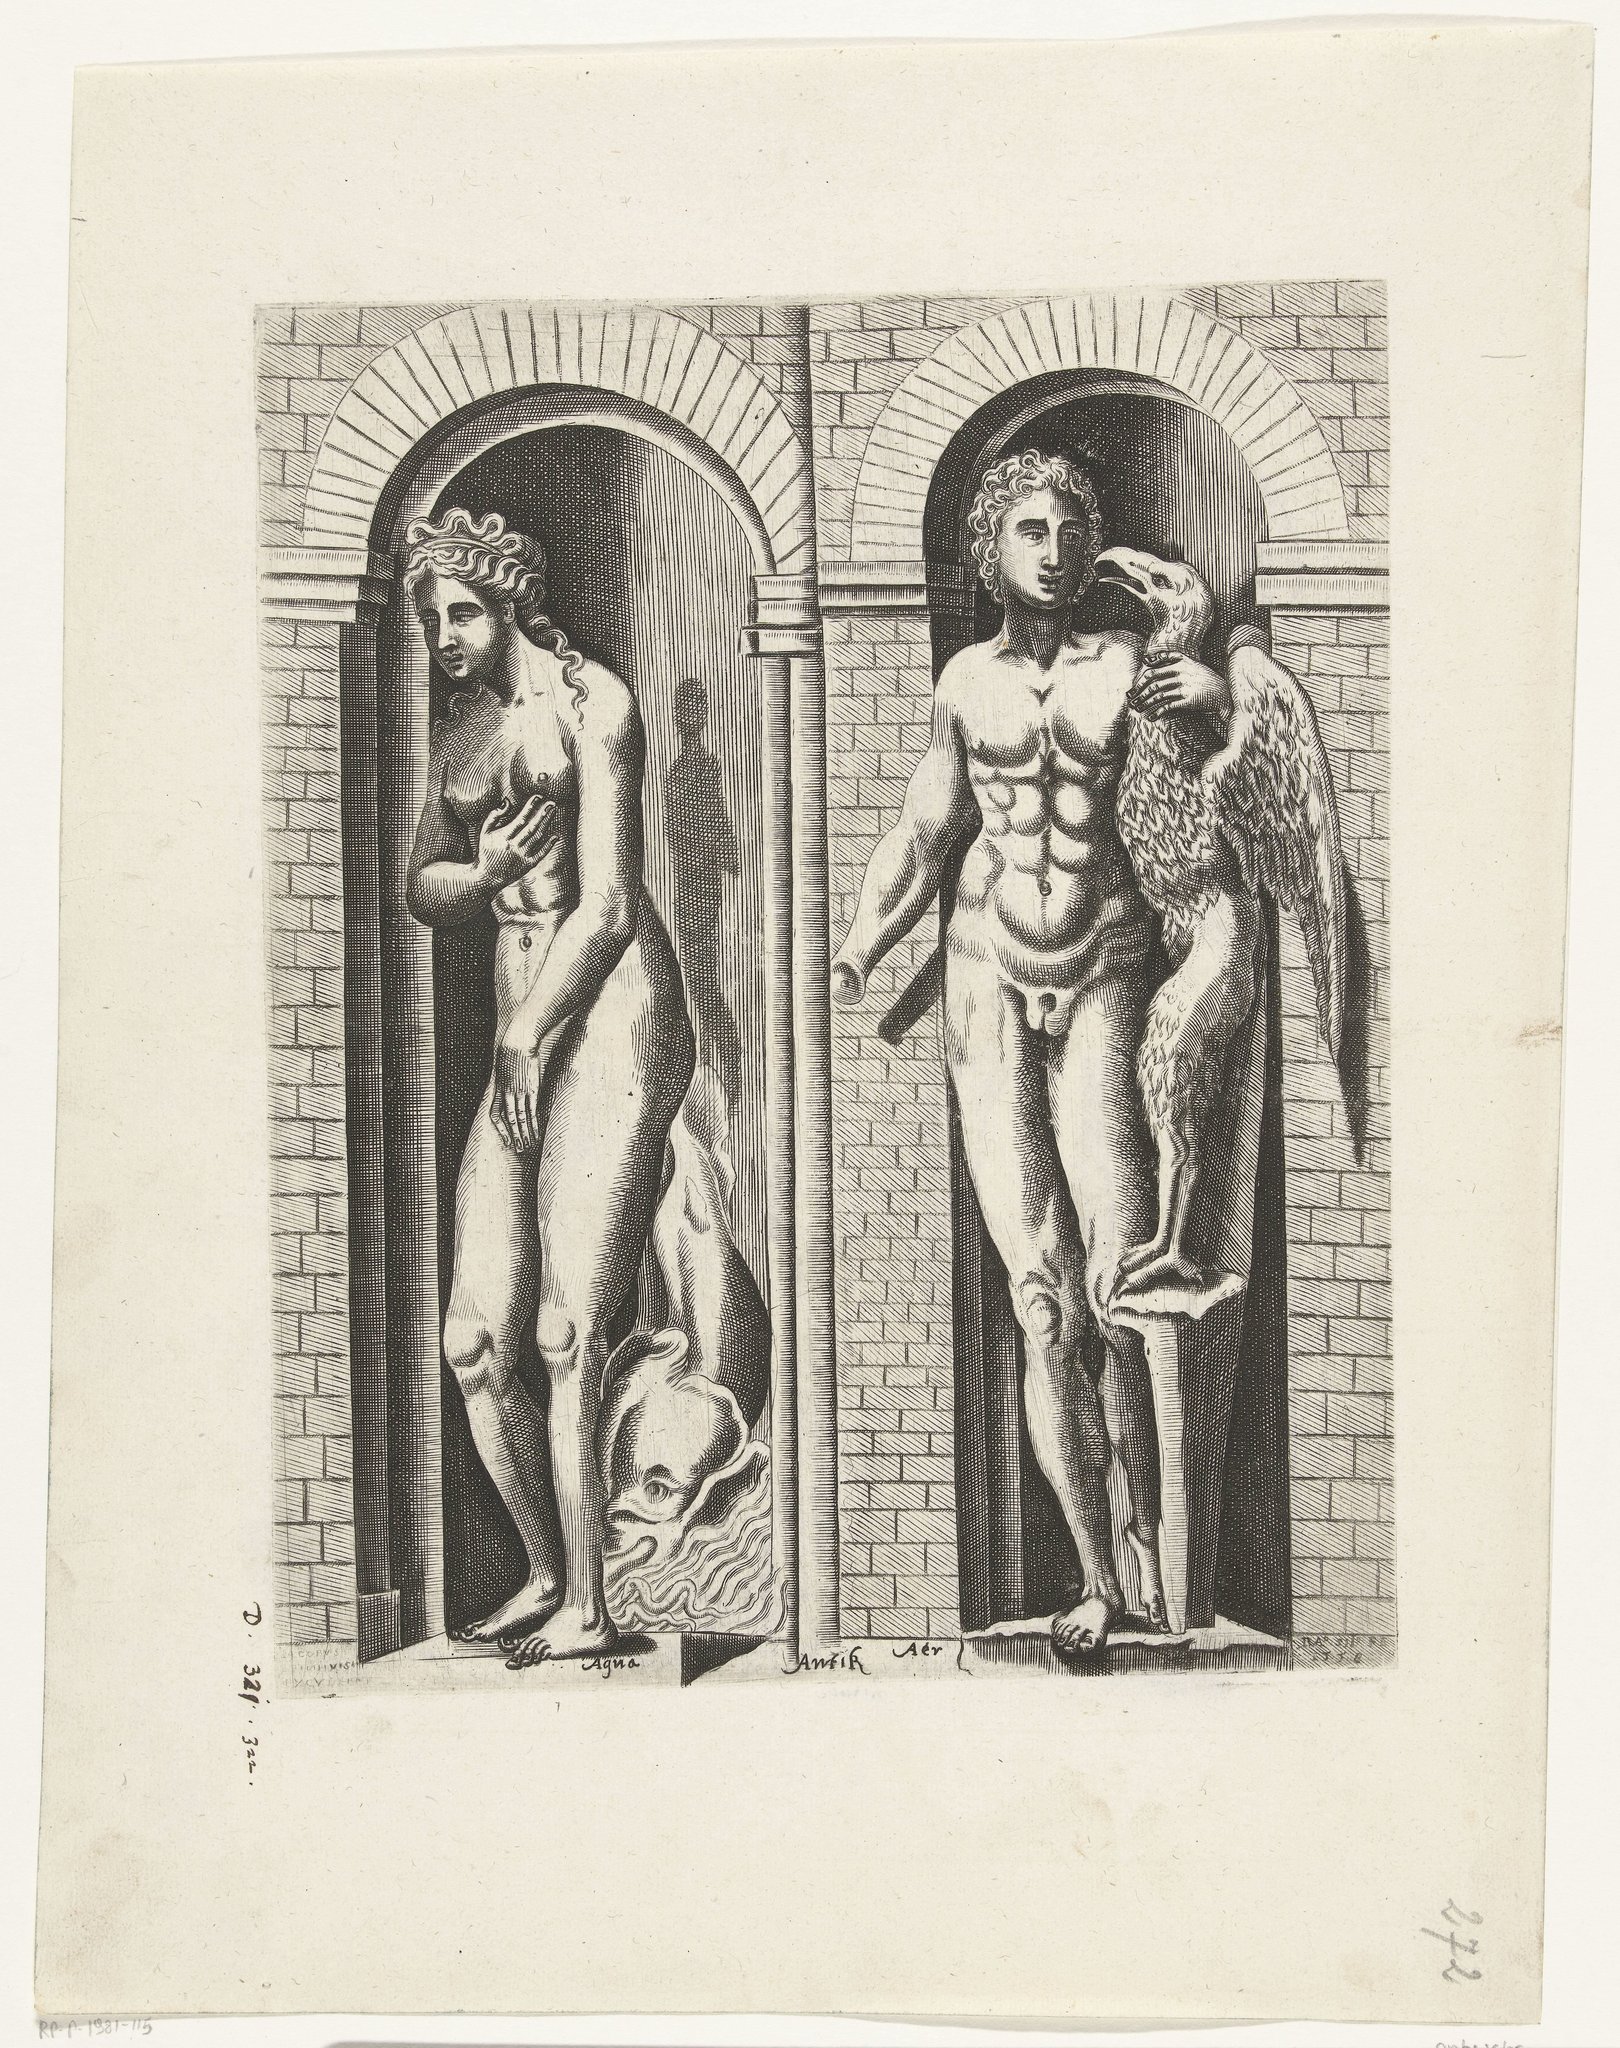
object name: print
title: Water en lucht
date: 1558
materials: paper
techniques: engraving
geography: antwerp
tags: air (one of the four elements), 'acqua', 'carro dell'acqua' (ripa)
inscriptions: serial number, collector's mark: Lugt 2760, collector's mark: Lugt 2228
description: Twee arcades met beelden. Links de personificatie van water en rechts de personificatie van lucht. Water is een naakte staande vrouw die zichzelf met haar handen bedekt. Een vis (dolfijn) bevindt zich naast haar voeten. Lucht is een naakte jongeling. In zijn linkerhand houdt hij een adelaar vast. Hij ontbreekt een rechterhand.